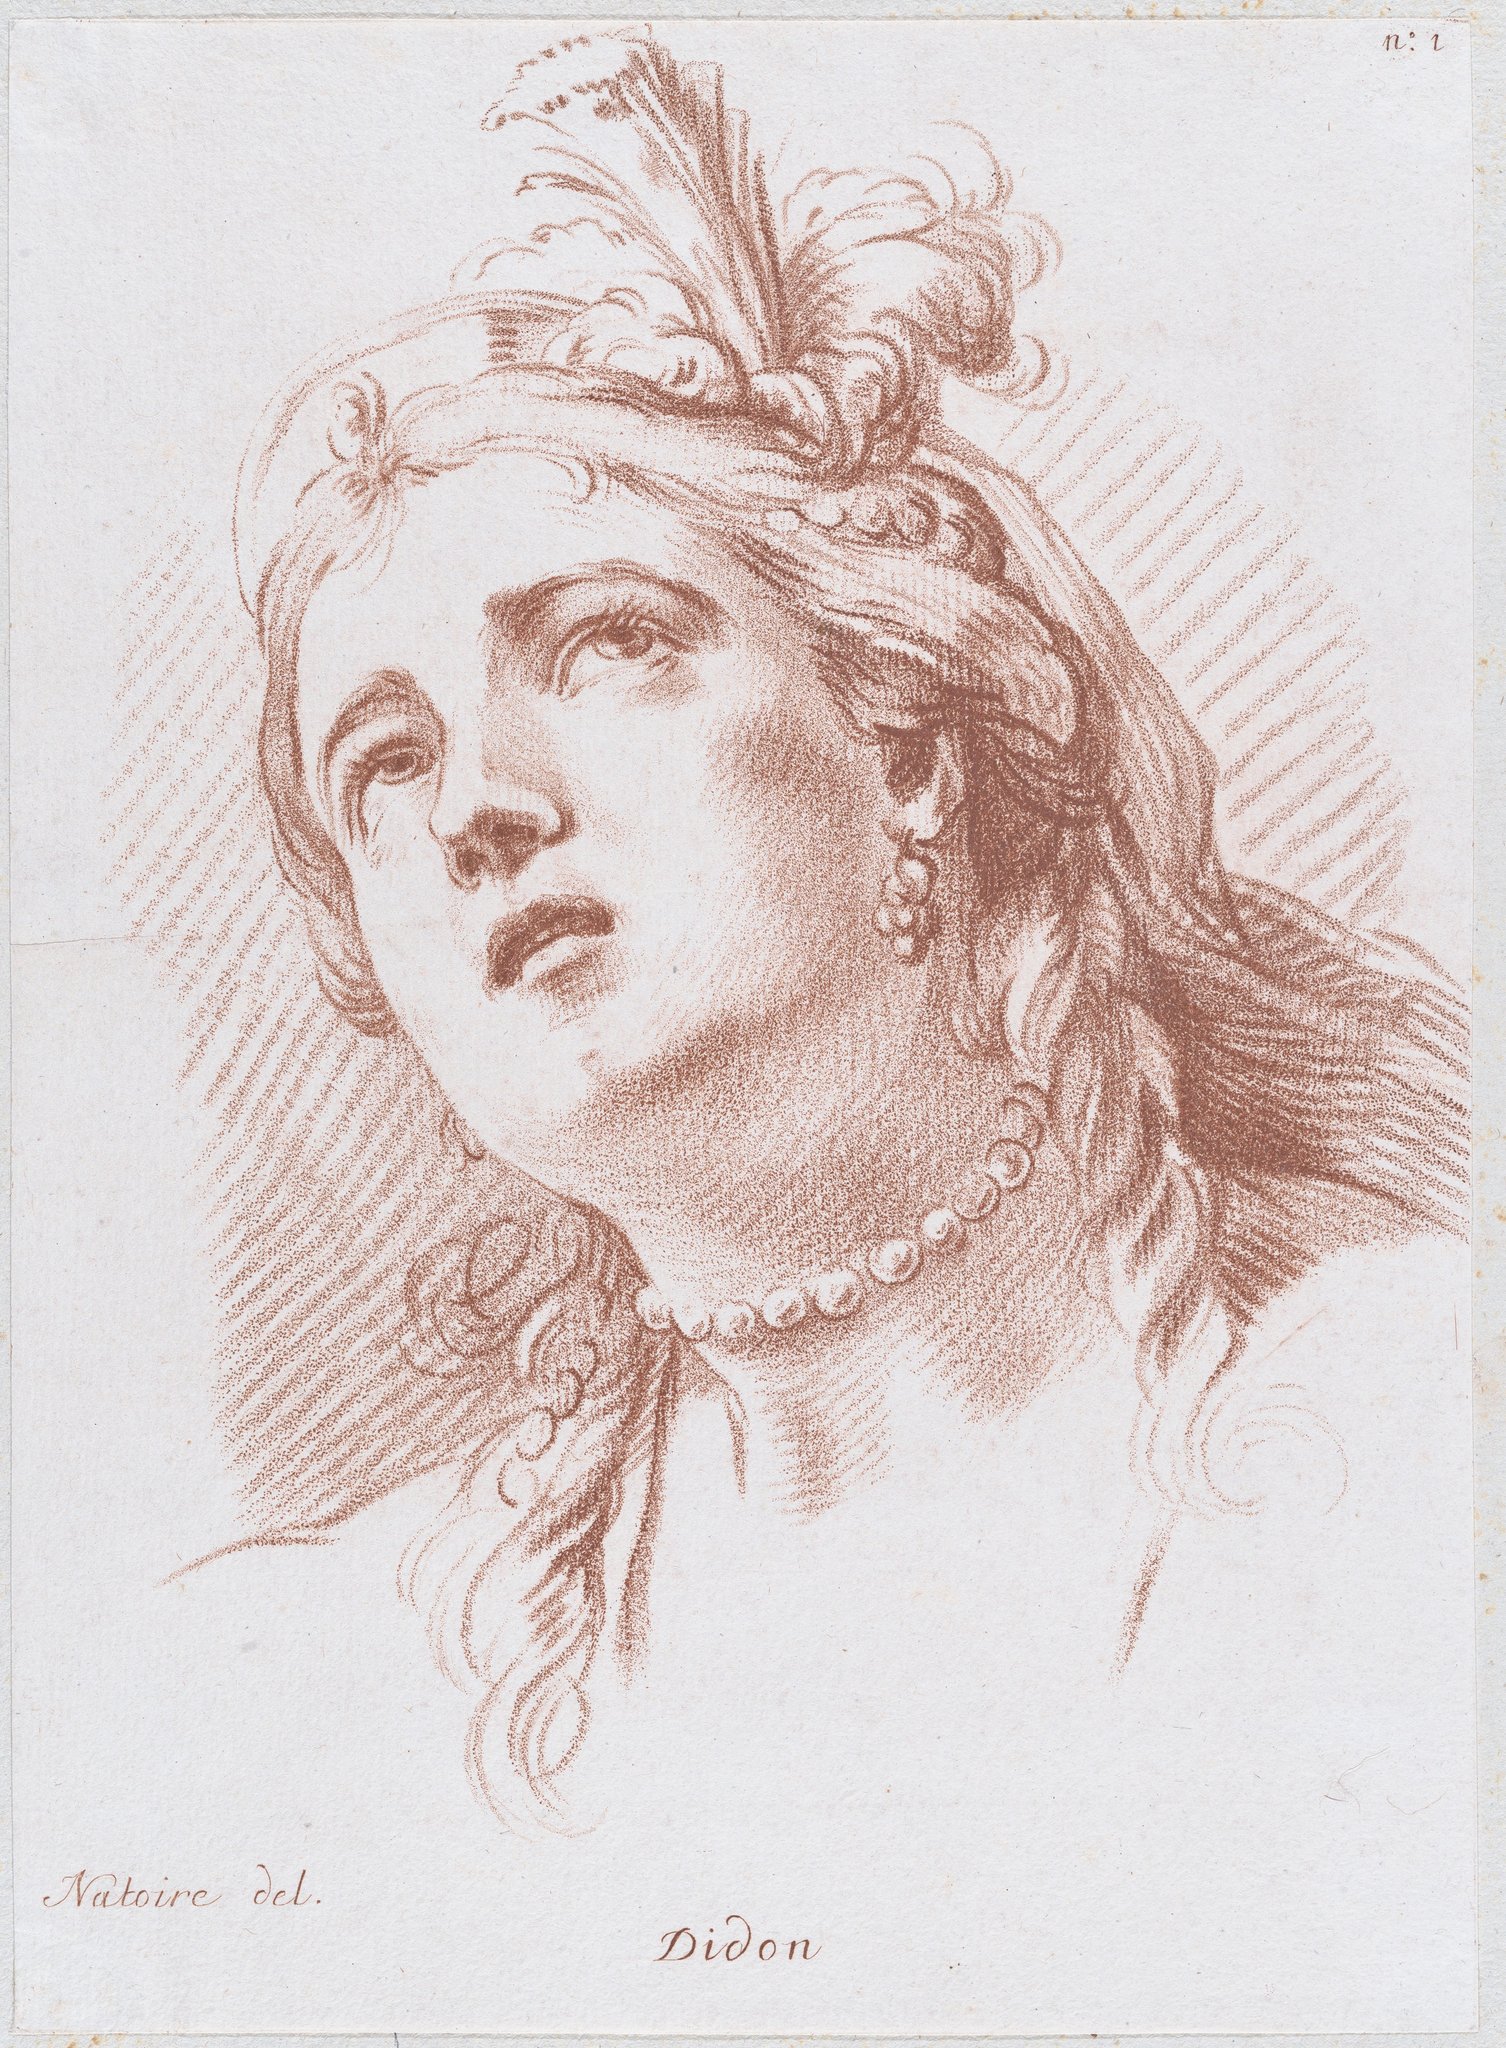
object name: print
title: Dido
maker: louis marin bonnet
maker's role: artist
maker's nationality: french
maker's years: 1736-1793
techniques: printmaking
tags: portraits,women